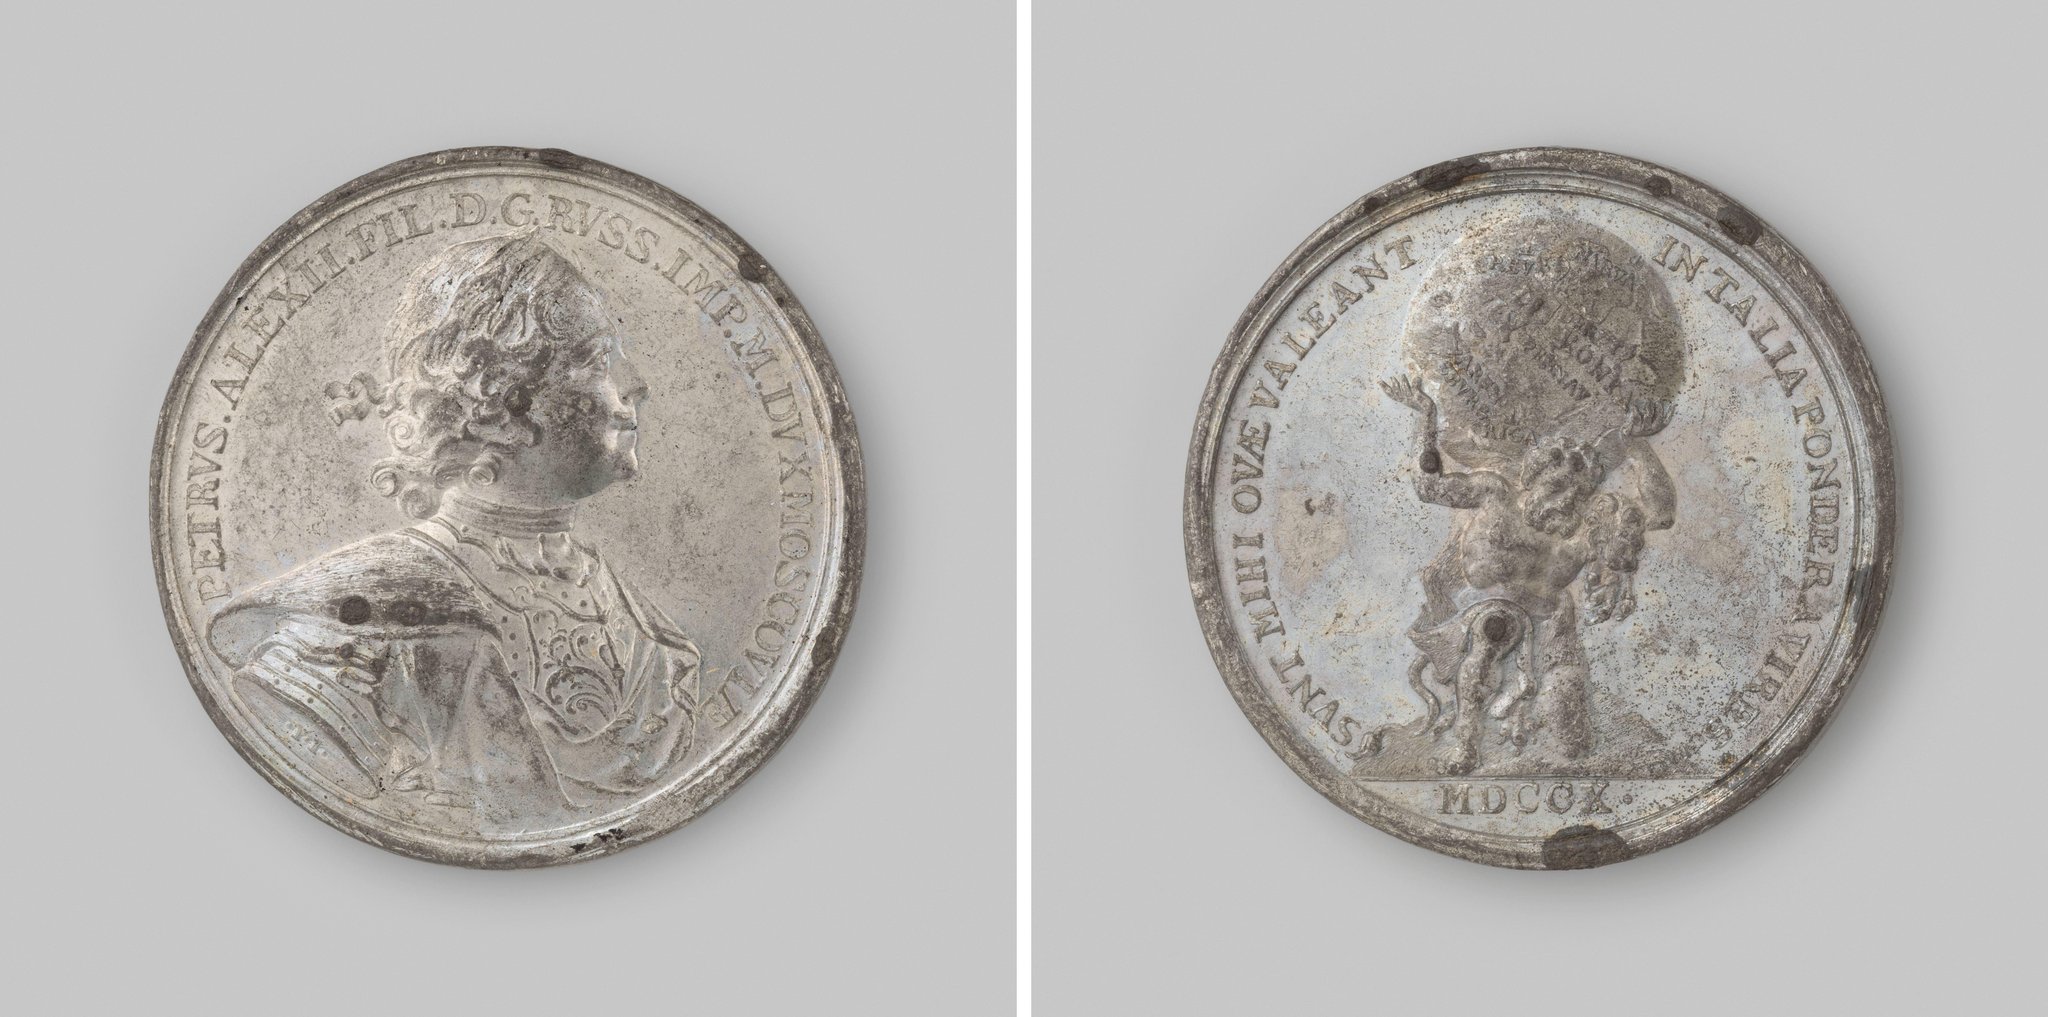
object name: history medal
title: Inname van Lijfland en Finland door Rusland op Zweden 1710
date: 1710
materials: tin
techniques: striking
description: Tinnen penning, op de voorzijde het borstbeeld van Tsaar Peter de Grote naar rechts met omschrift, op de keerzijde Hercules de wereldbol torsend waarop de plattegrond van het strijdtoneel, met omschrift en afsnedetekst.